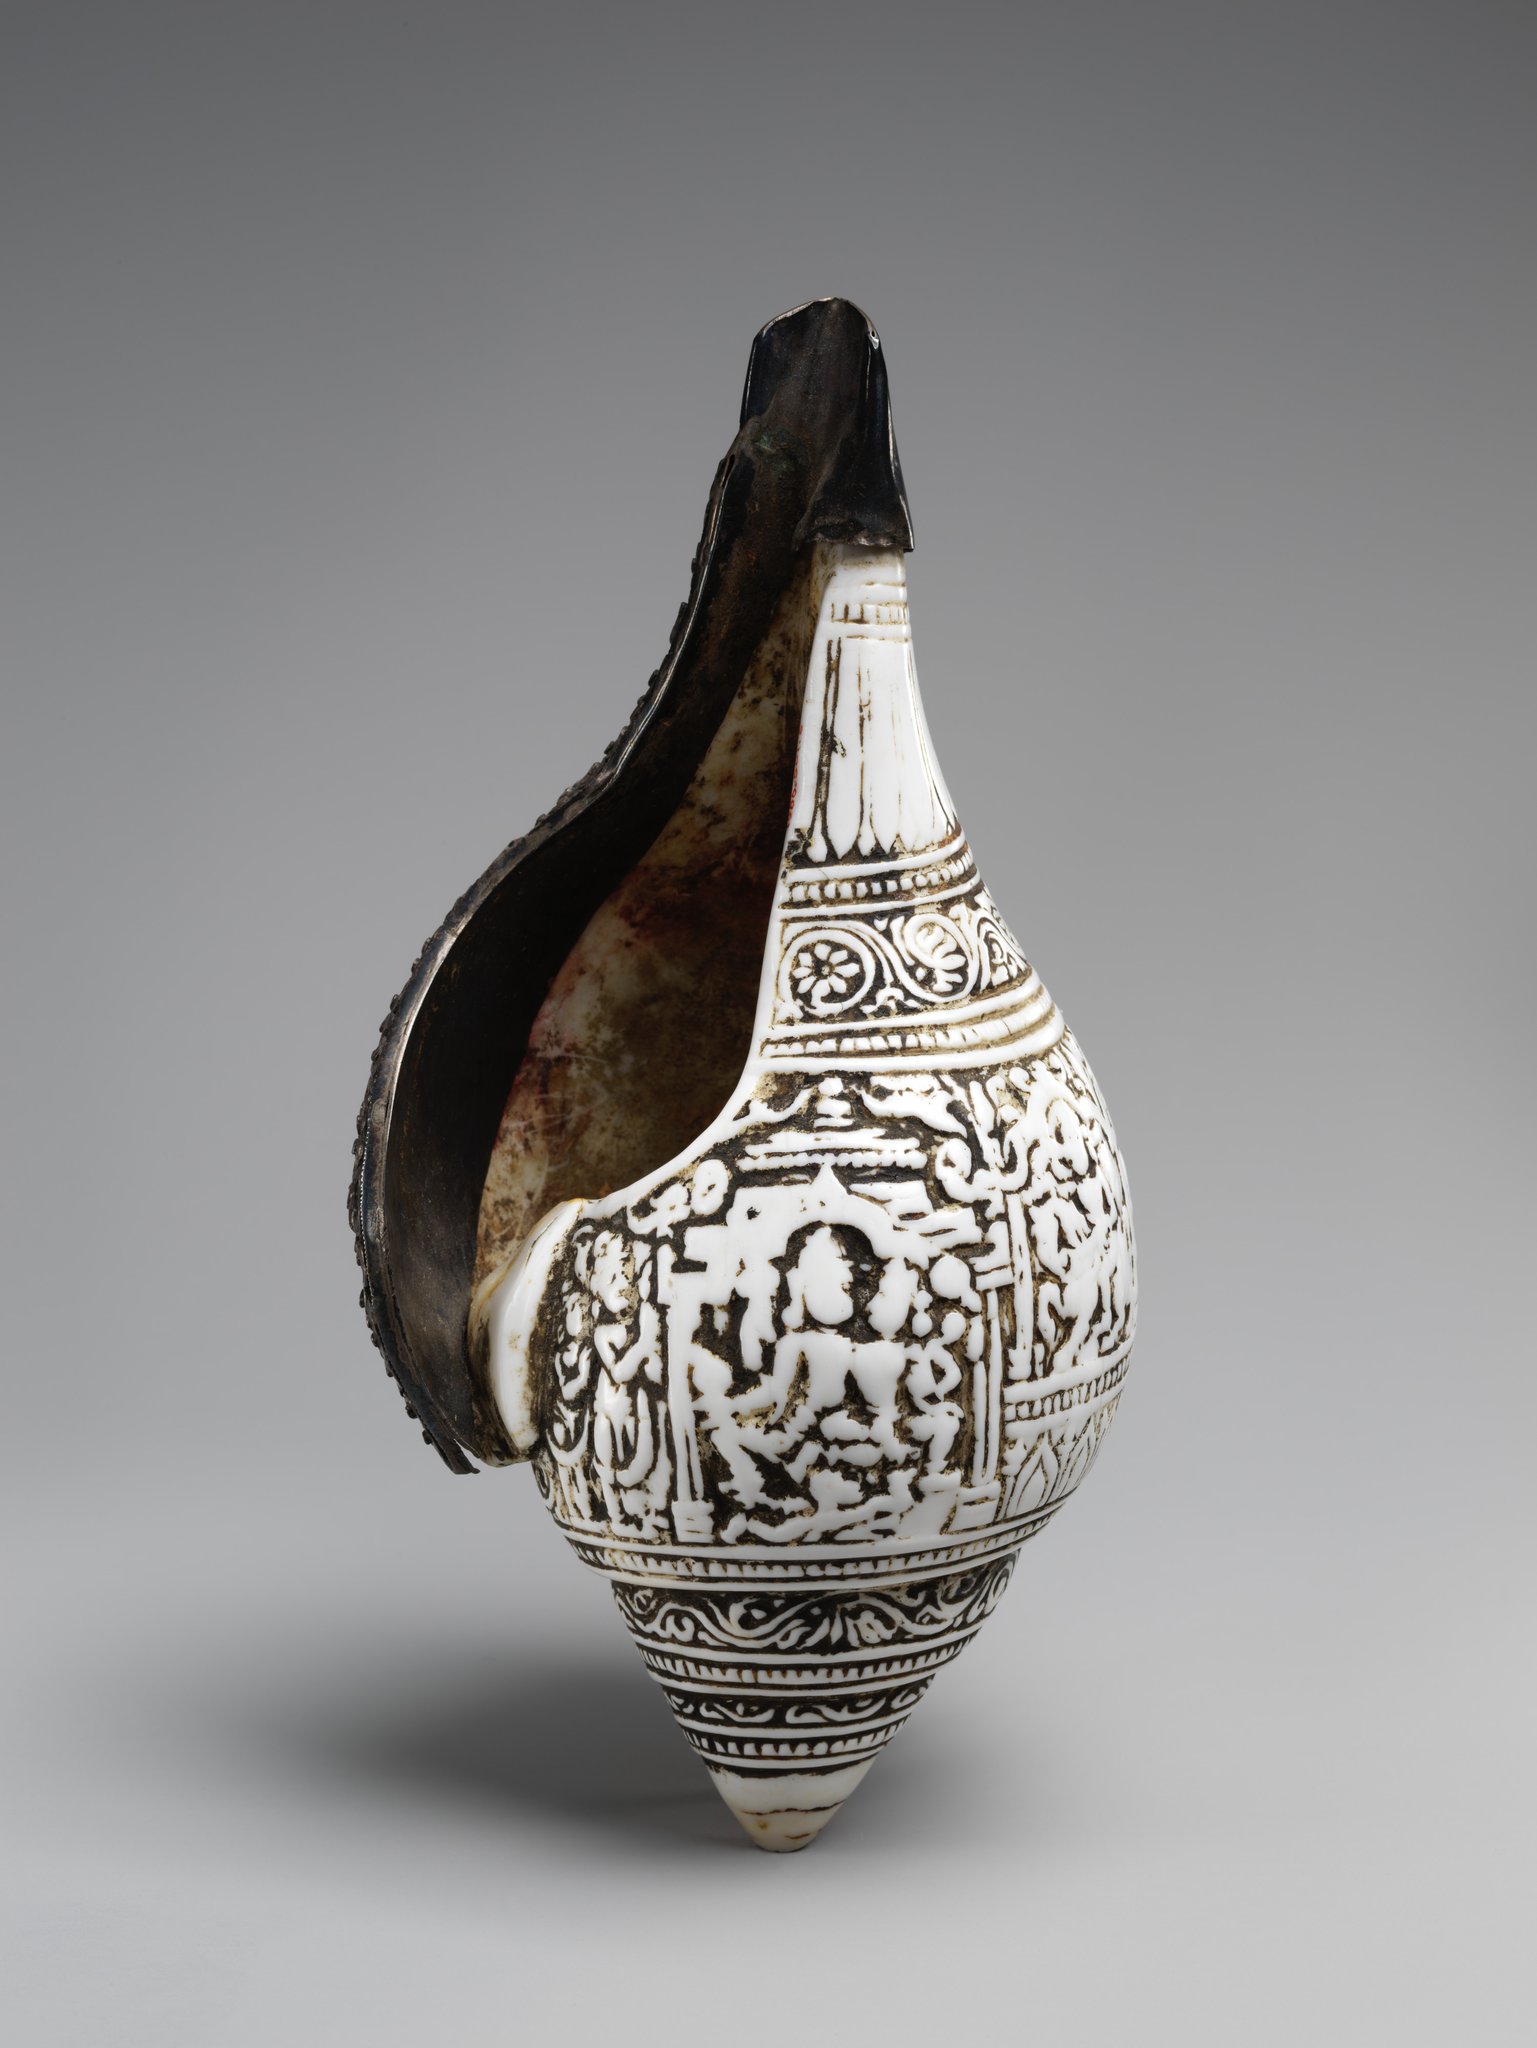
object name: conch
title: Carved Conch with Lakshmi-Narayana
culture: indian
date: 1001-1200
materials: shell, silver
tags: vishnu